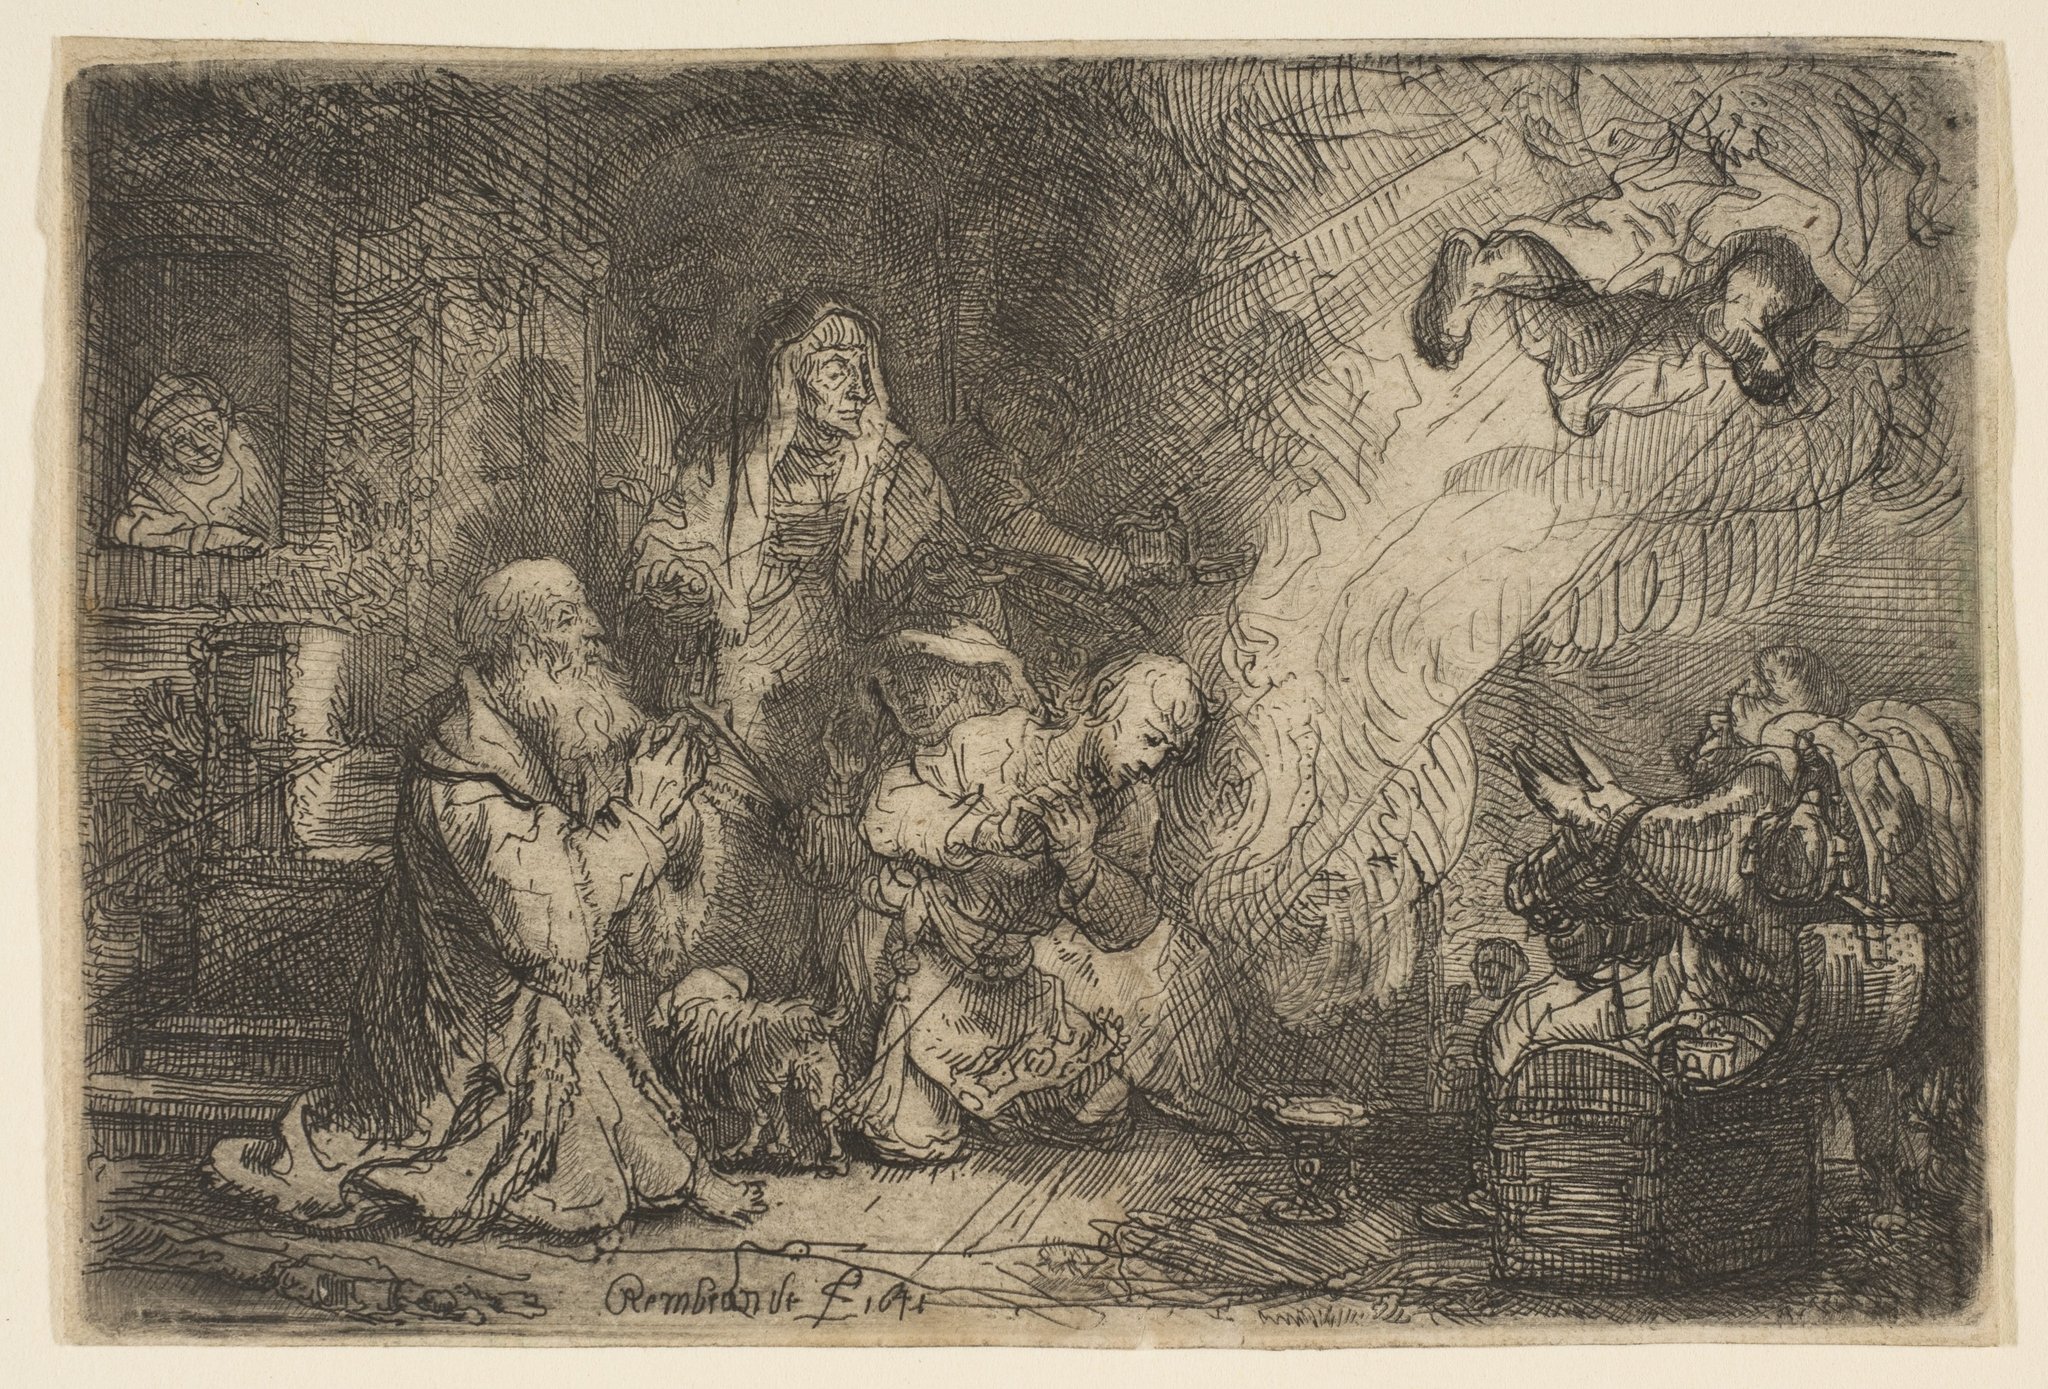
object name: print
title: The Angel Departing from the Family of Tobias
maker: rembrandt van rijn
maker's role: artist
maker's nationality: dutch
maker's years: 1606-1669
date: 1641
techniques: drypoint, etching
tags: men,women,angels,family